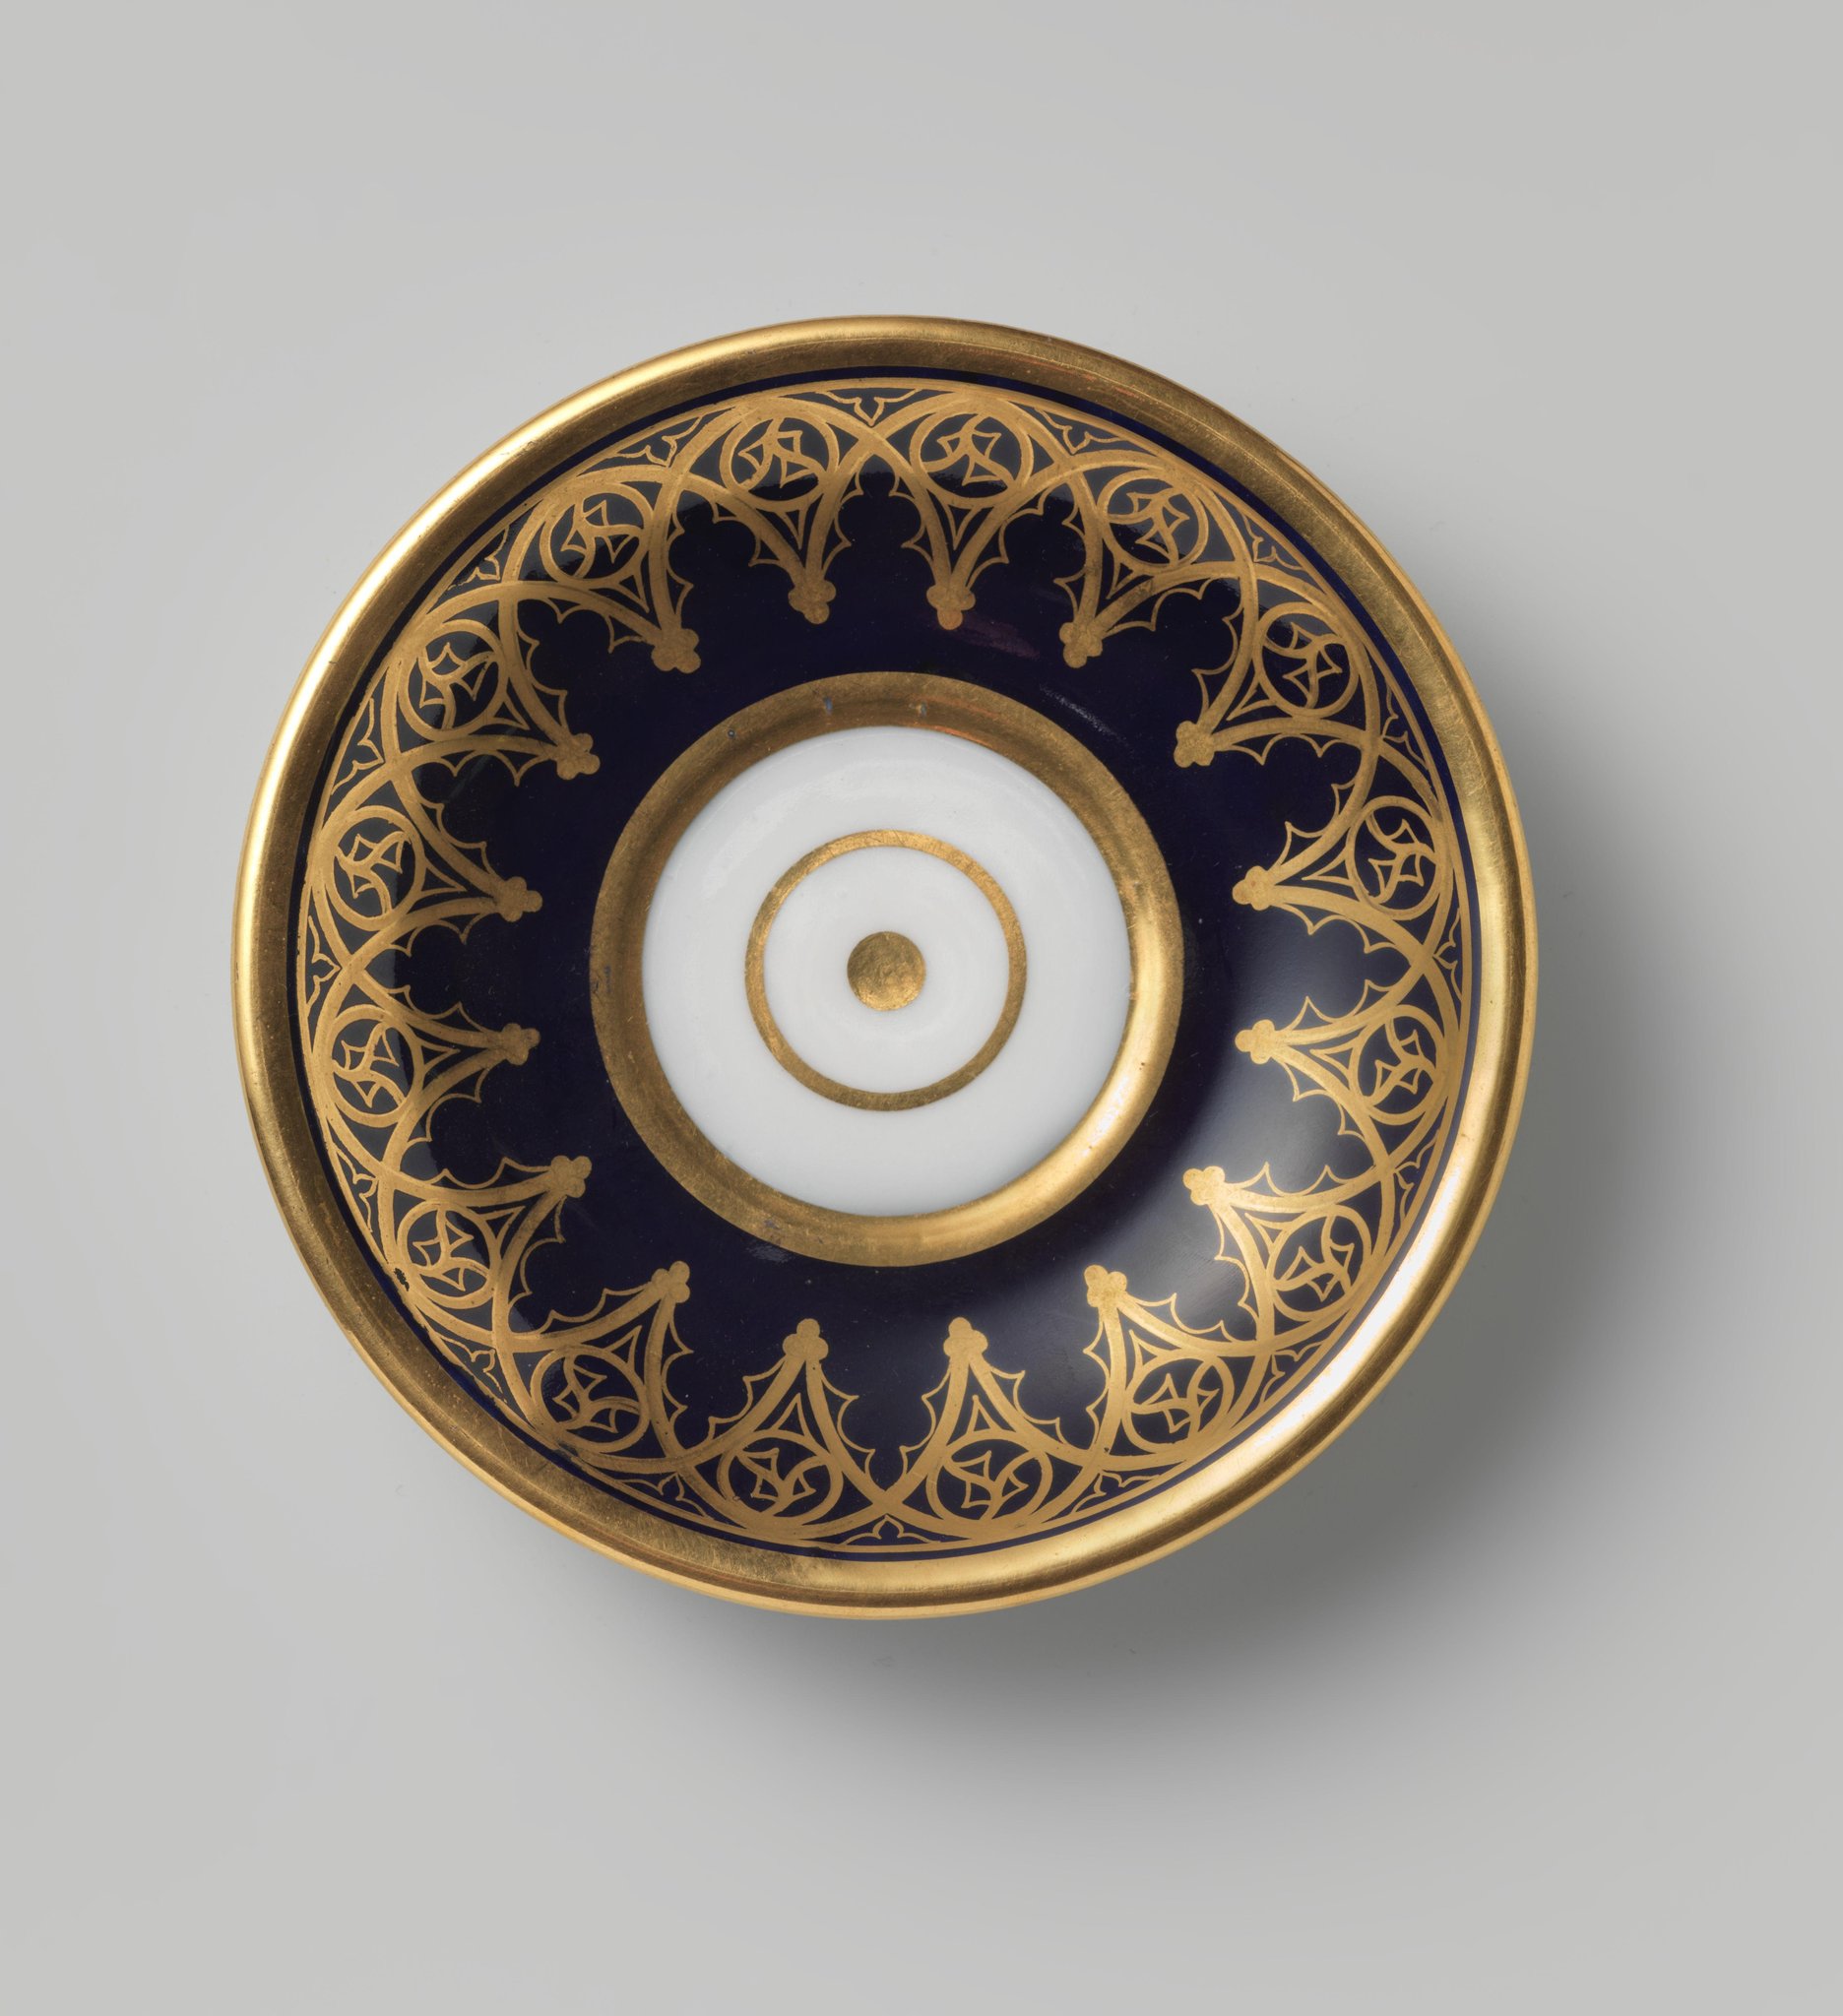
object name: service set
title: Saucer with a gothic arcade decoration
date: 1800-1899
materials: cobalt, glaze, gold, paint, porcelain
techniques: firing, forming, gilding, turning, vitrification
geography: saint-yrieix-la-perche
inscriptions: mark: ‘vis/ No 14’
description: Schotel van porselein, deel van servies, beschilderd in goud op een koningsblauw fond met een arcademotief met gotische traceringen. Buiten dit decor en voor een groot deel aan de binnenzijde verguld. Gemerkt met een groen visje. Opmerking: zie voor merken ook het algemeen record.